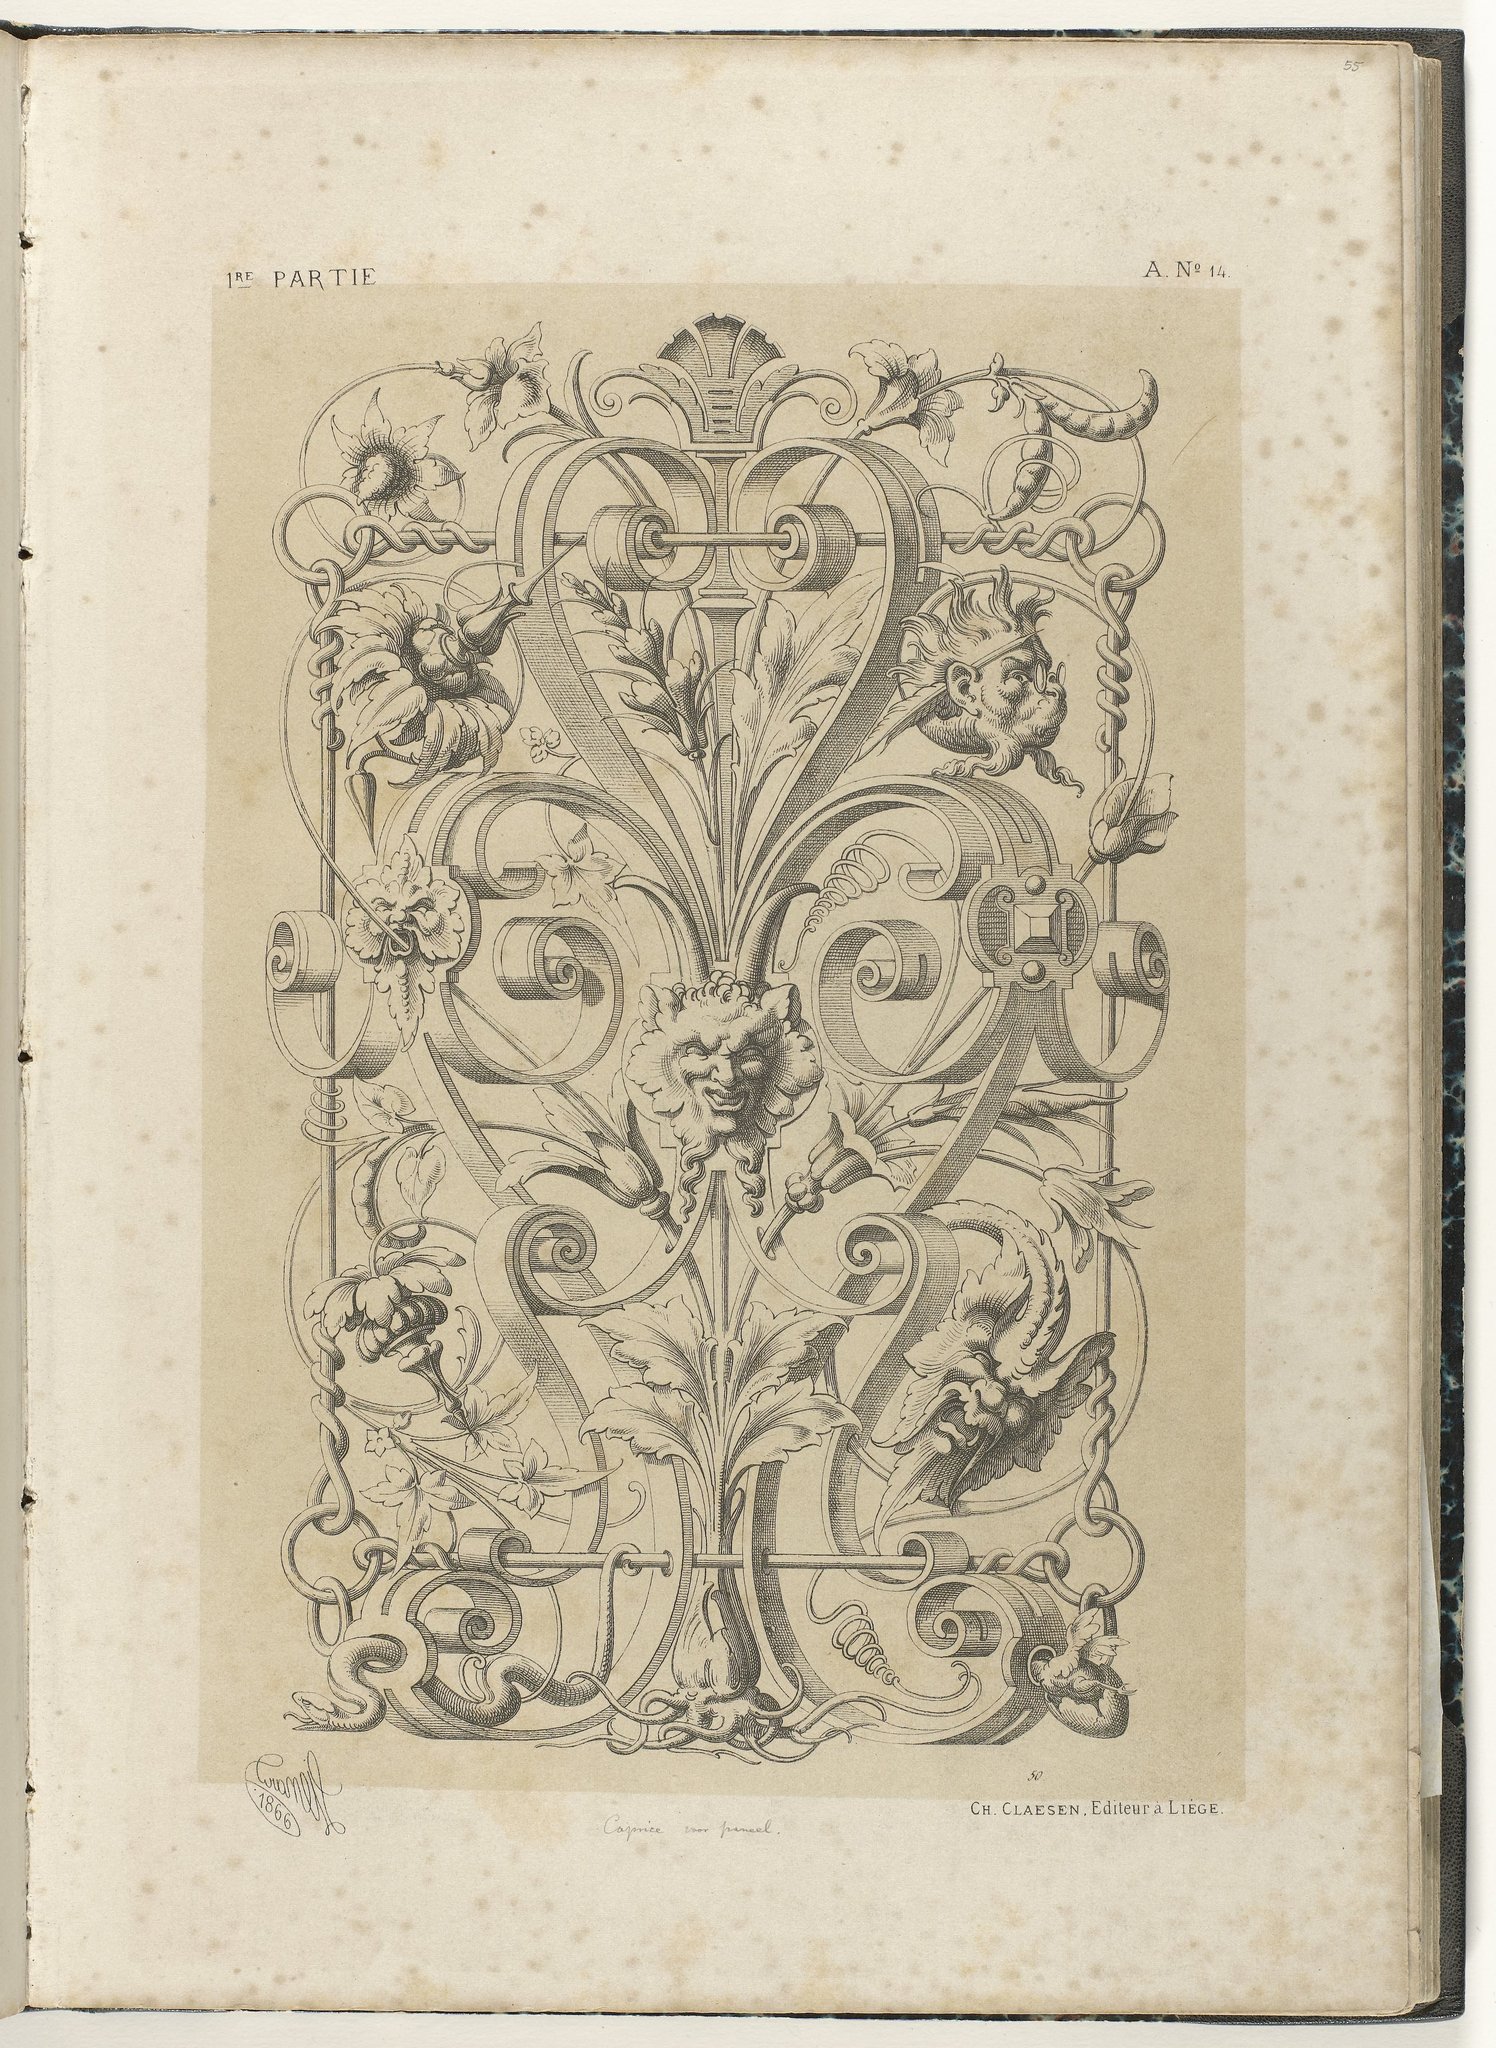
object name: print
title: Paneel met satermasker tussen bladranken en rolwerk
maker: michel liénard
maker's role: print maker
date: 1866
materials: paper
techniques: tone lithography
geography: liège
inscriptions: annotation: ‘Caprice voor paneel.’